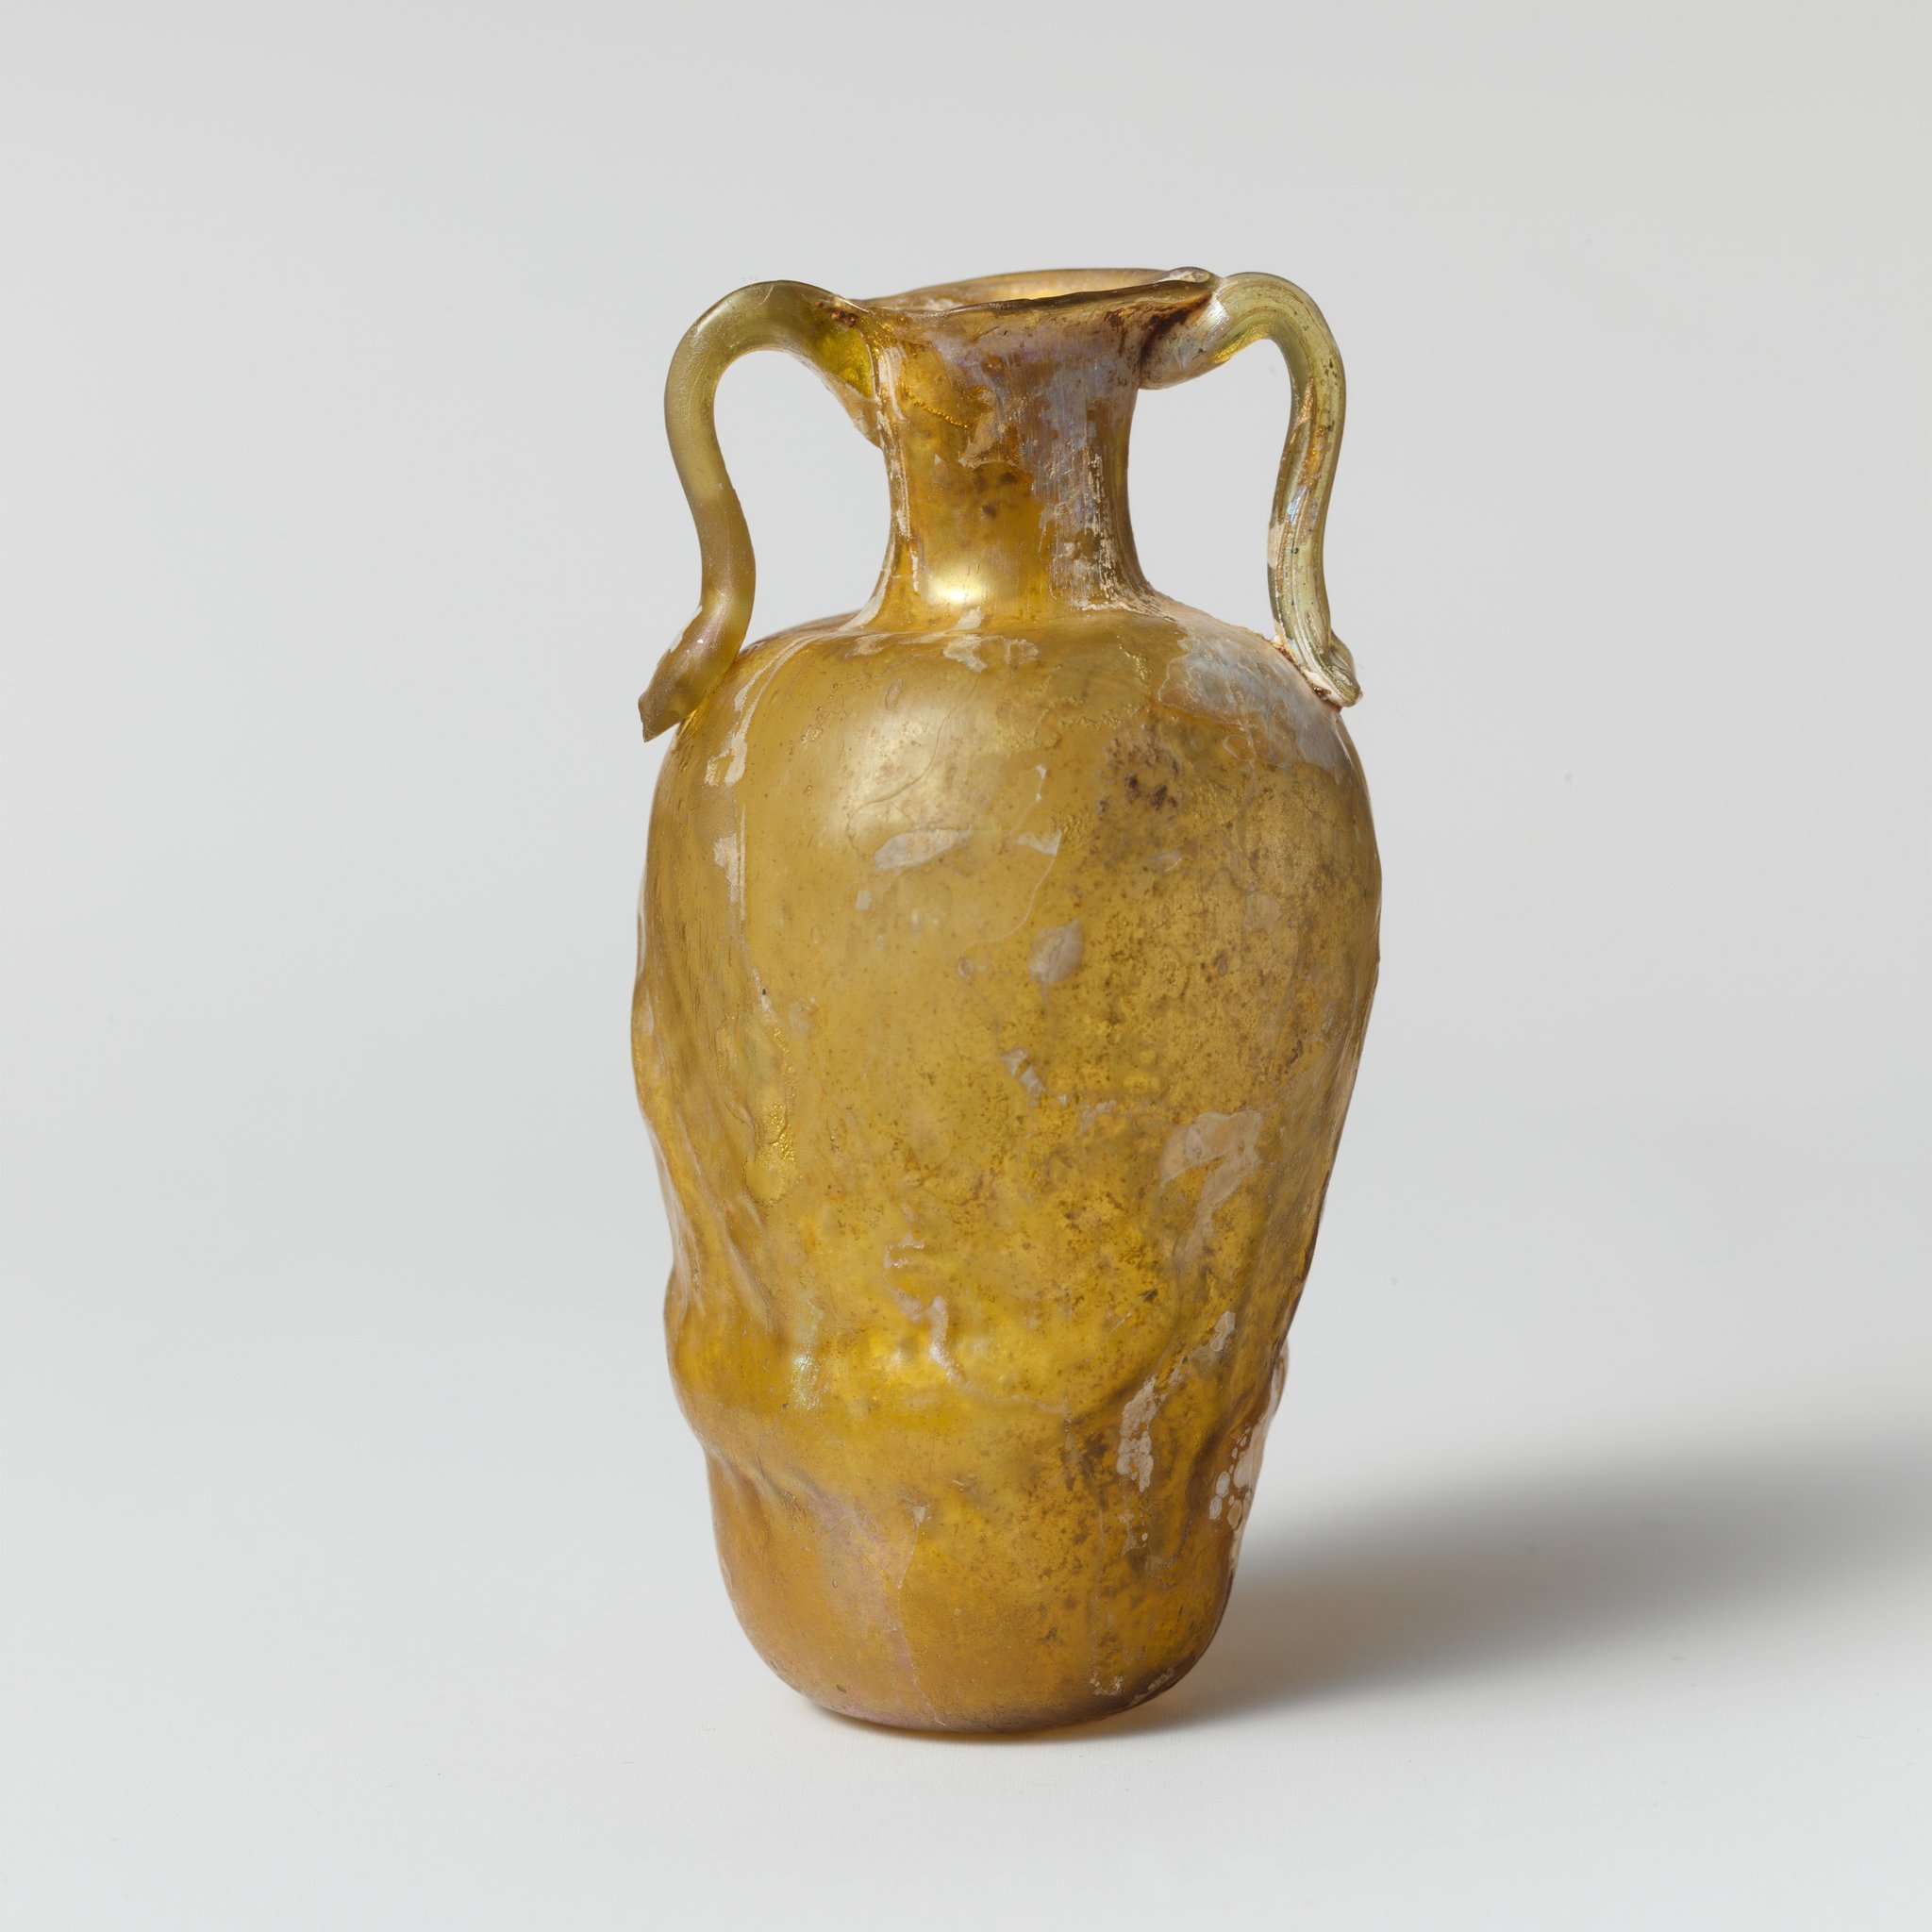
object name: amphoriskos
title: Glass amphoriskos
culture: roman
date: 1-100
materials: glass